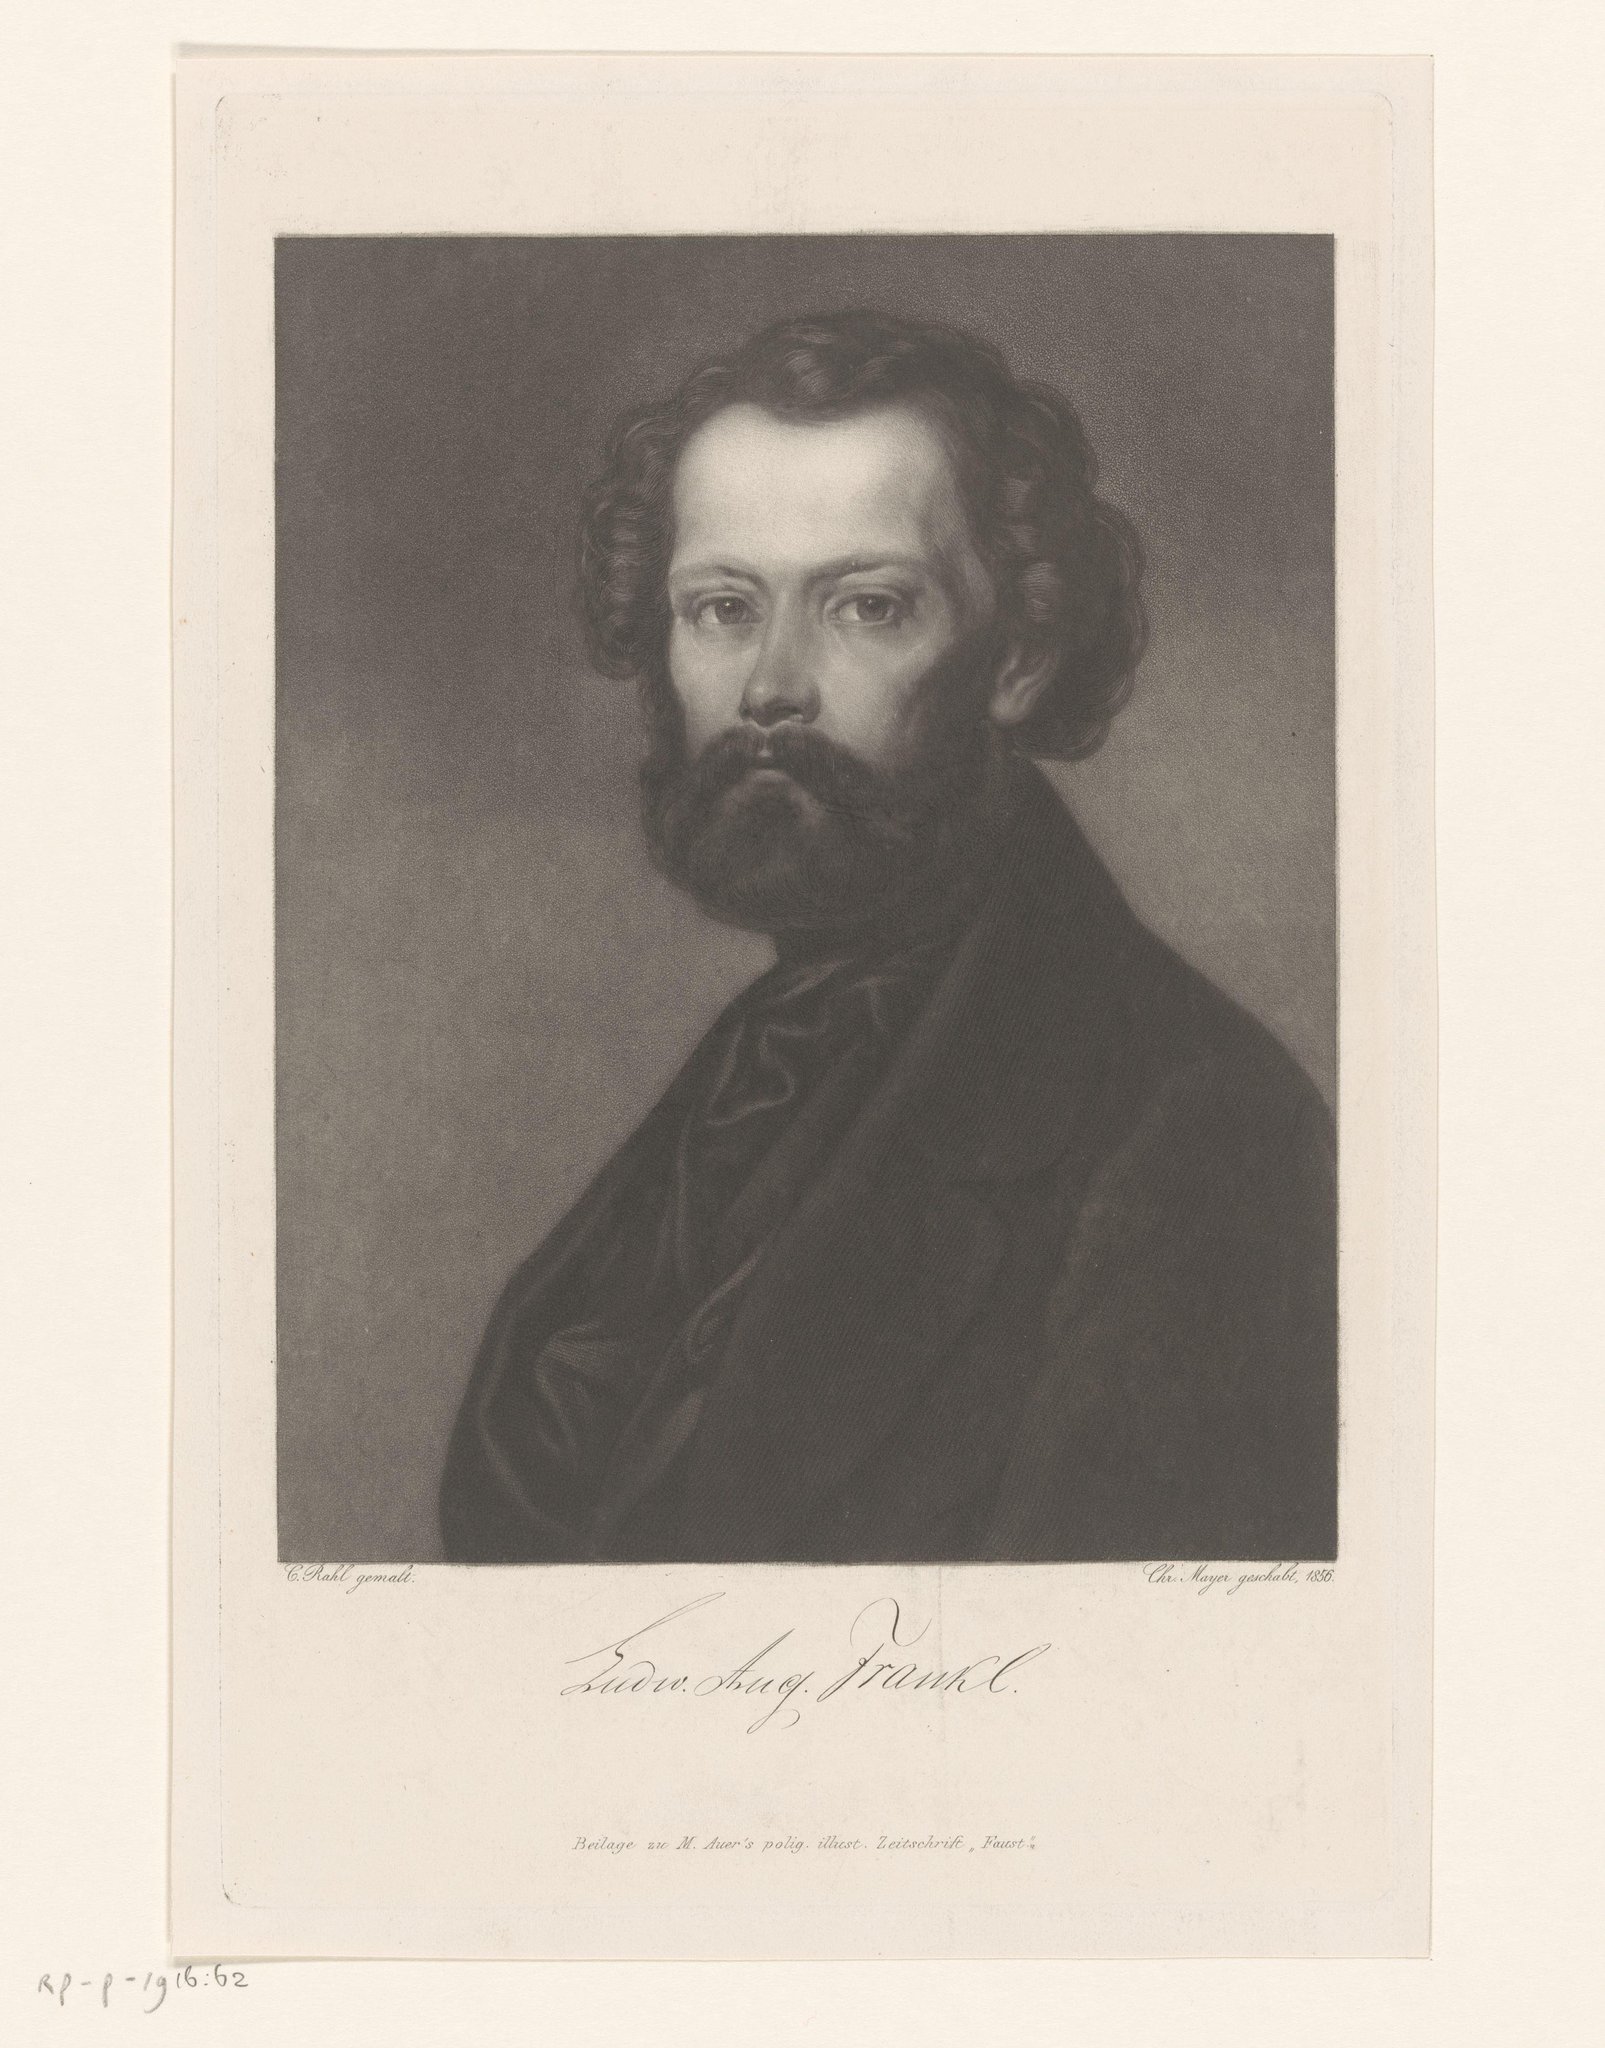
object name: print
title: Portret van Ludwig August Ritter Frankl von Hochwart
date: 1856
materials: paper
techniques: mezzotint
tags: publisher, historical persons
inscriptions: collector's mark: Lugt 2228